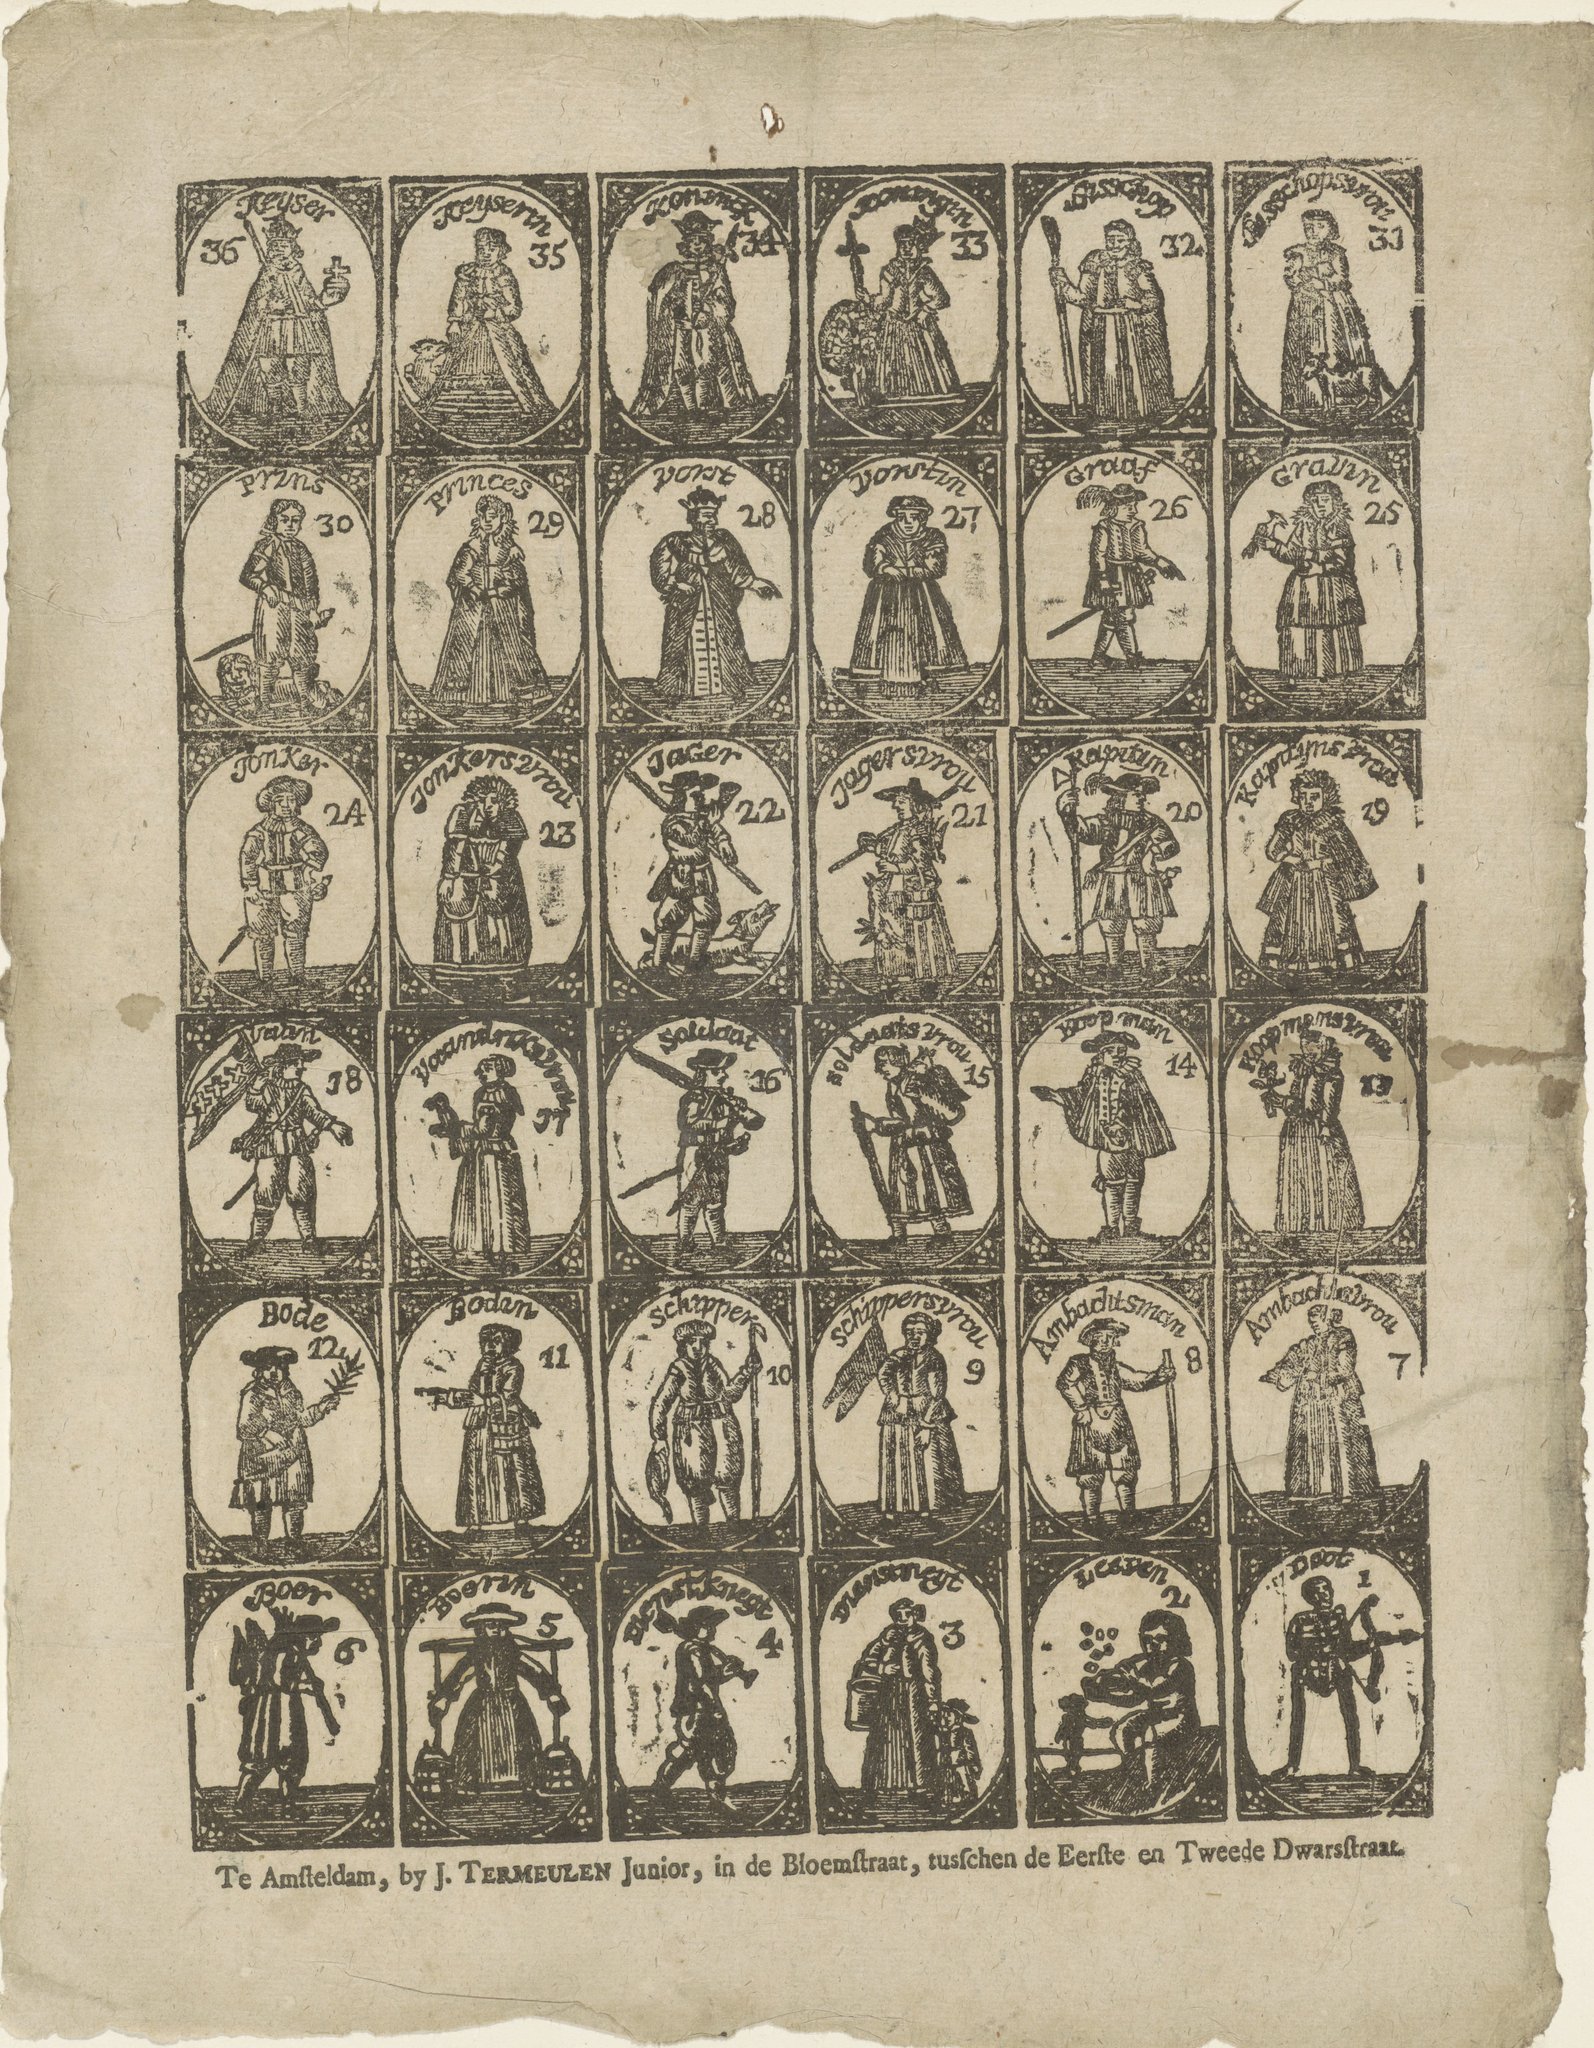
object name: popular print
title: Floskaartjes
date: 1789-1804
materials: paper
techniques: letterpress printing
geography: netherlands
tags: symbols and personifications of death, social position, playing-cards, nobility and patriciate; chivalry, knighthood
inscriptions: collector's mark: Lugt 2760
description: Blad met 36 speelkaarten (floskaartjes) met voorstellingen van verschillende figuren. De afbeeldingen vormen achttien paren, aflopend genummerd van bovenaan links nummer 36 tot onderaan rechts nummer 1. Op de twee laagste nummers na tonen ze zeventien koppels, man en vrouw, met de man net één nummer hoger dan de vrouw, waarbij elk paar een beroep of een maatschappelijke positie voorstelt.